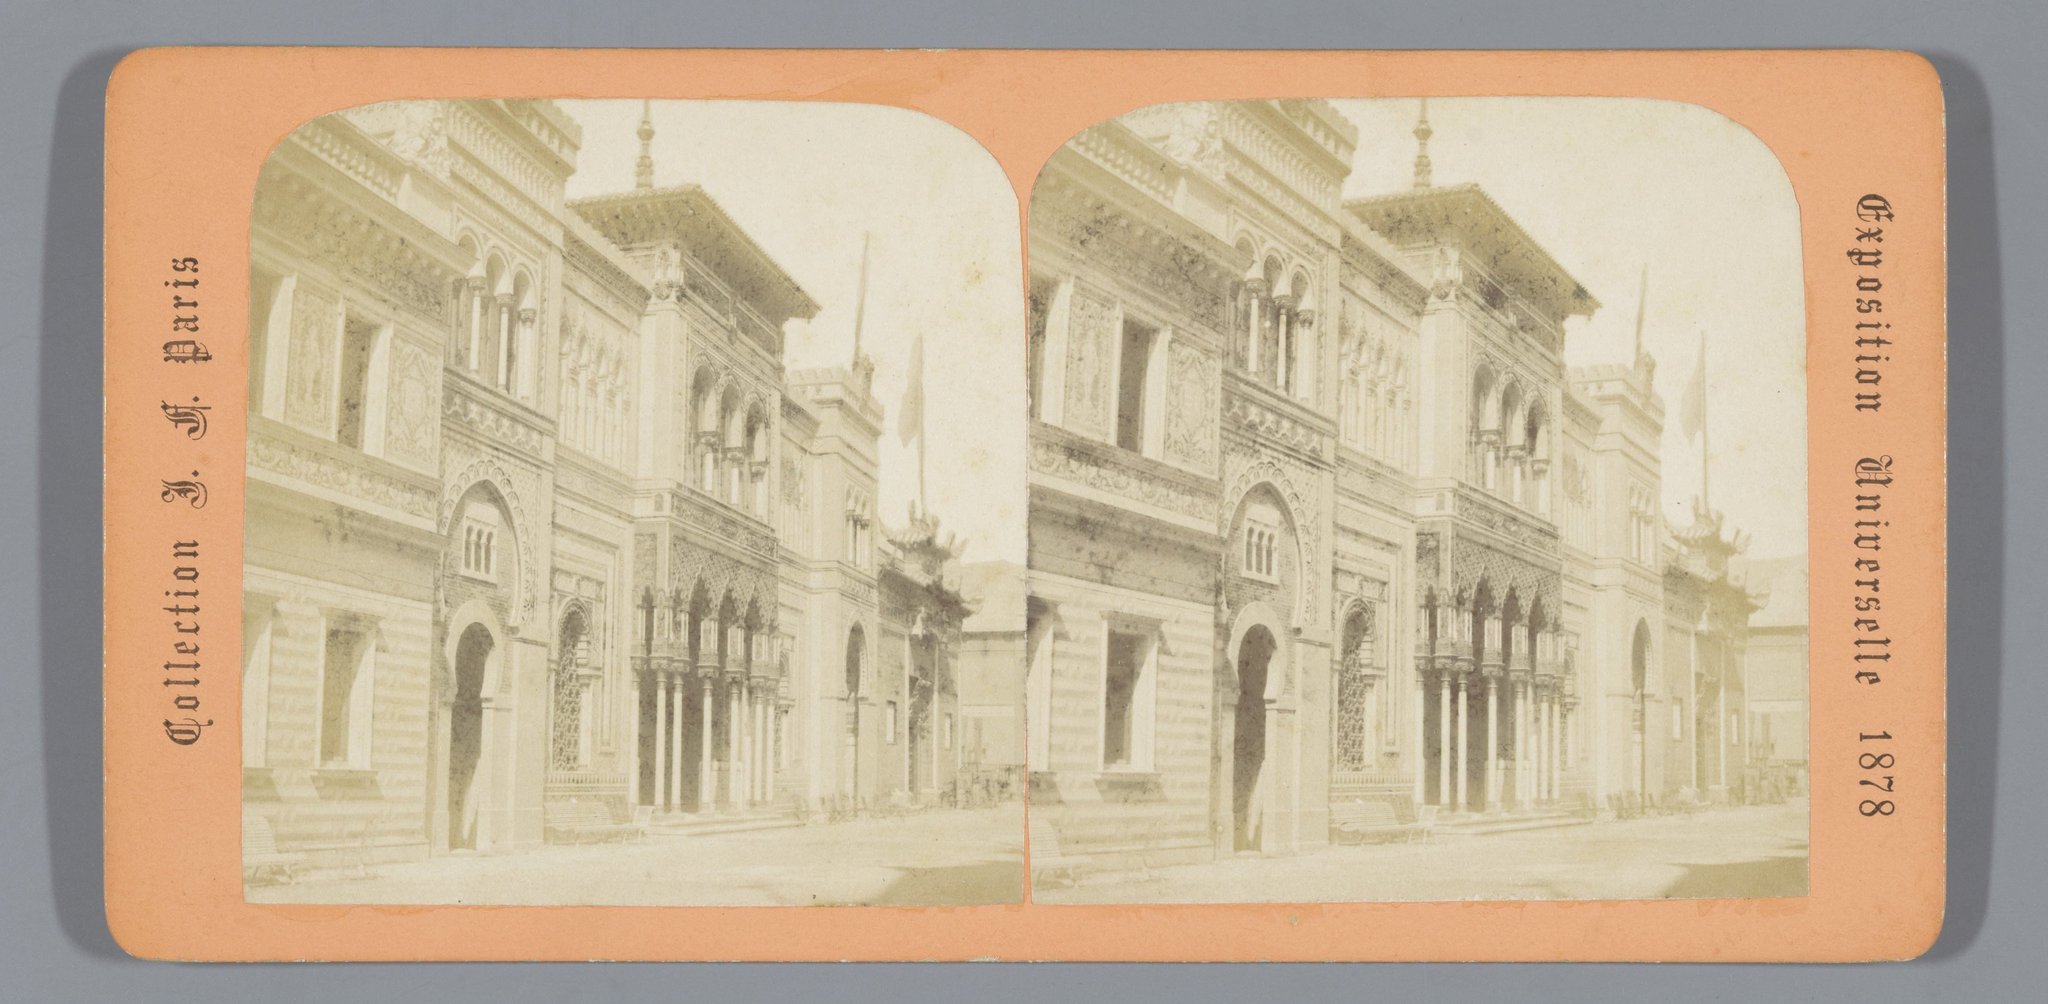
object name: stereograph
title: Spaanse paviljoen op de Wereldtentoonstelling van 1878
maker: jf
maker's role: fotograaf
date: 1878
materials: cardboard, paper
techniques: albumen print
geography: paris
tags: world fair, world exhibition, paris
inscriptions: inscription: ‘Espagne’